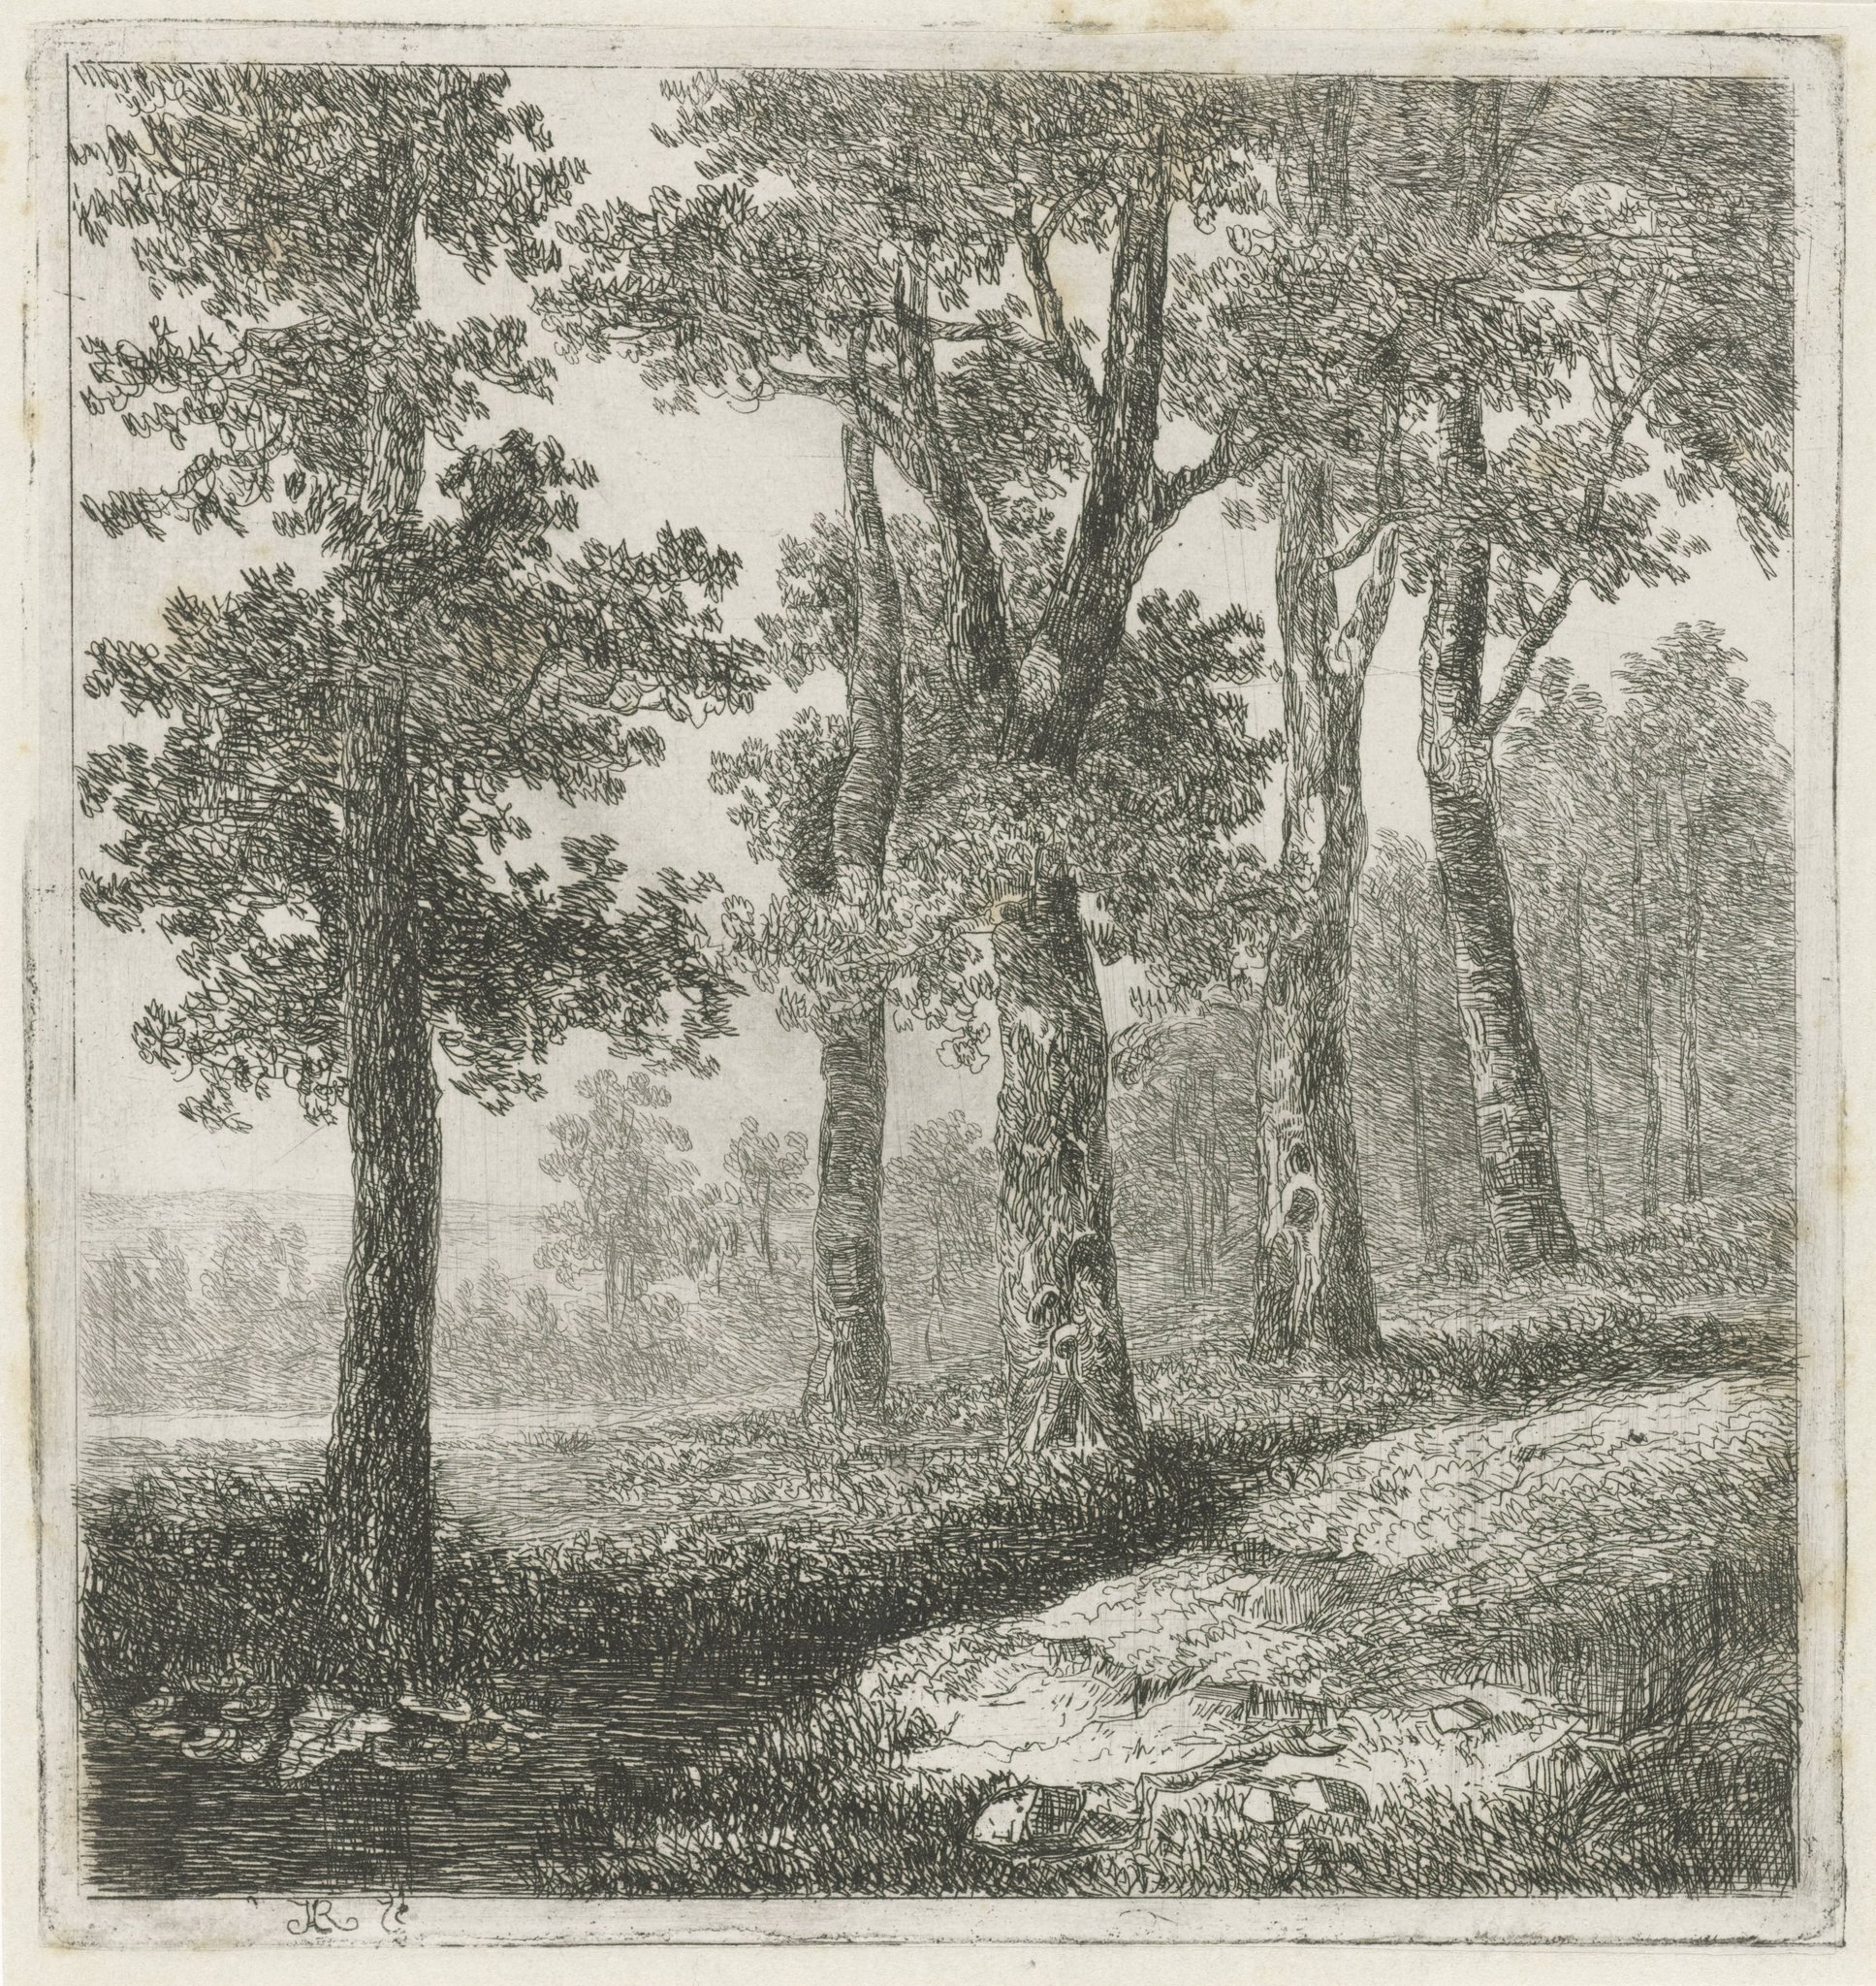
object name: print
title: Gezicht op een bosrand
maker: hermanus jan hendrik van rijkelijkhuysen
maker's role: painter, print maker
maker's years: 1813-1883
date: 1823-1883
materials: paper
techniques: drypoint, etching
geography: utrecht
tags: forest, wood, brook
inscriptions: collector's mark: Lugt 2228, collector's mark: Lugt 1485